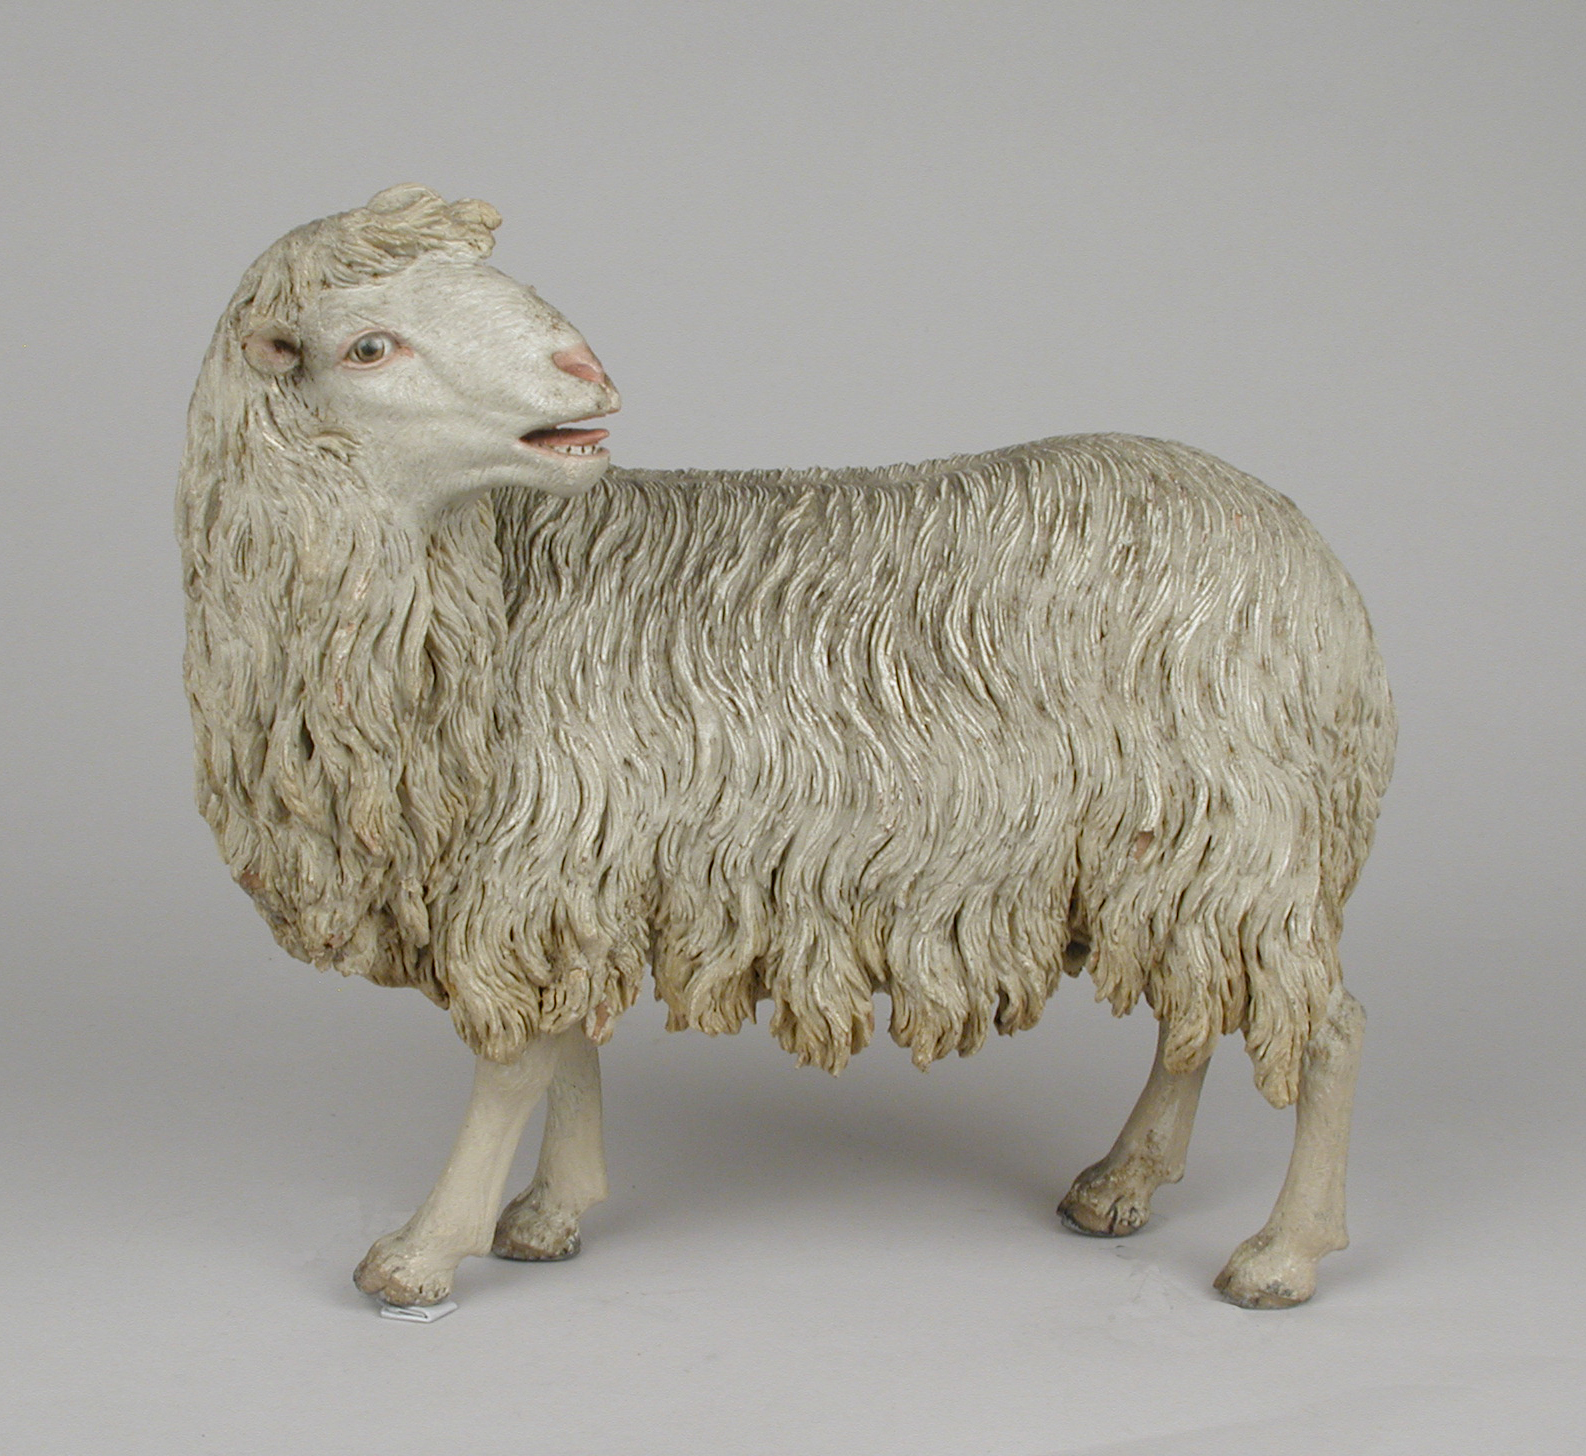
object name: crèche figure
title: Standing sheep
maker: nicola vassalo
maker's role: maker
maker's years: 1725-1825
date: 1751-1800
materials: lead, terracotta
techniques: polychrome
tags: sheep